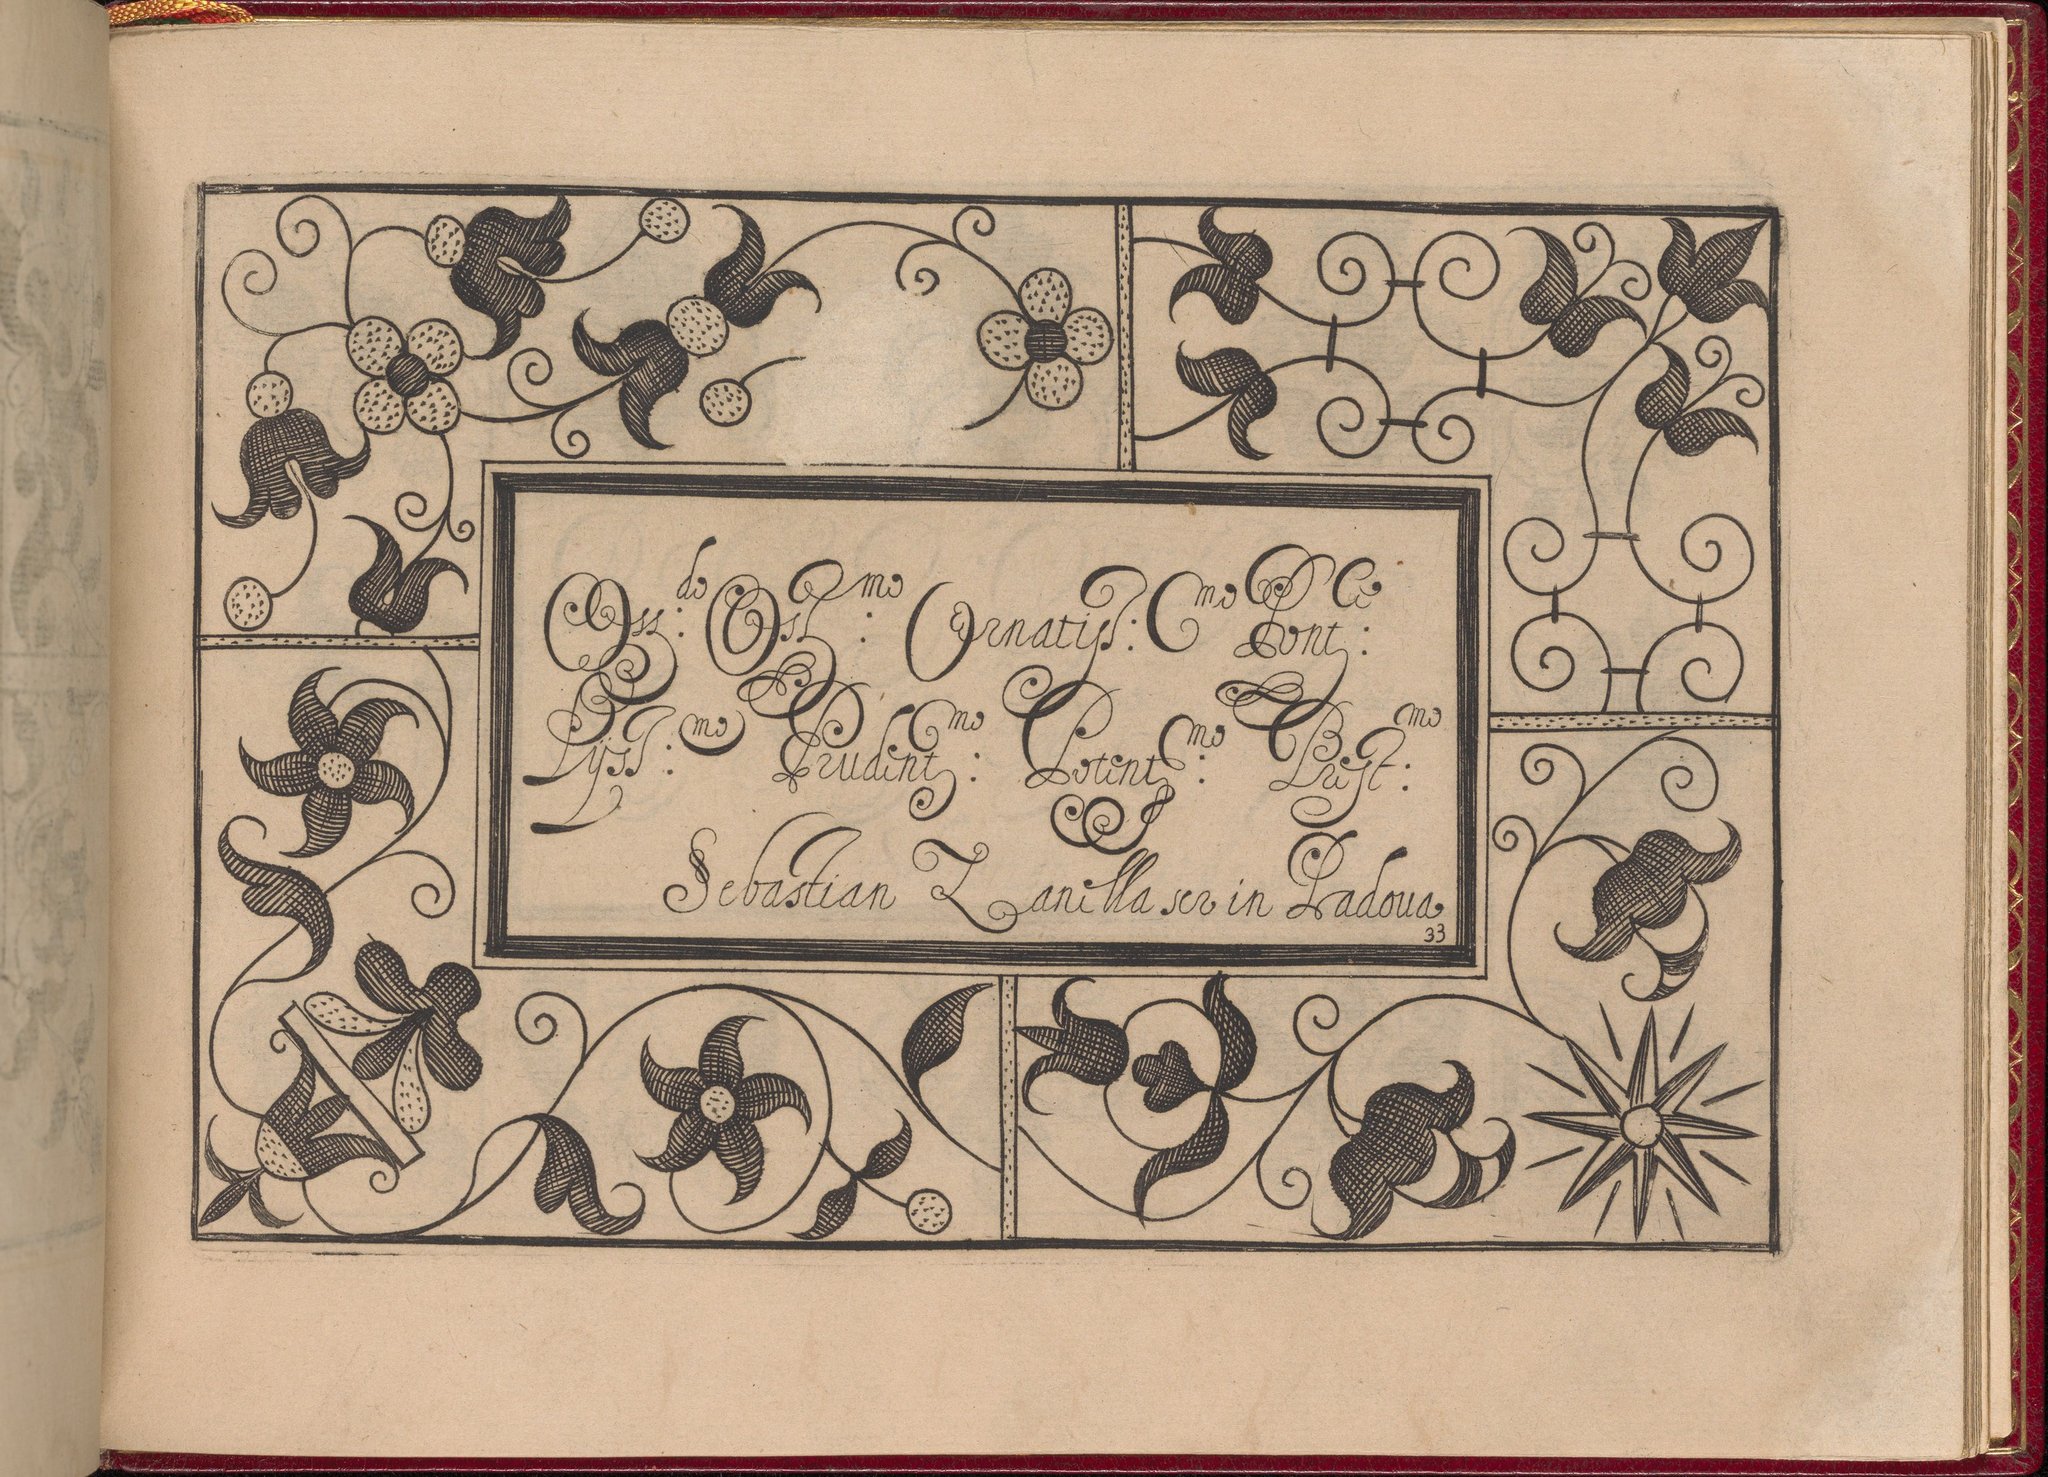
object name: book print ornament architecture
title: Ghirlanda: Di sei vaghi fiori scielti da piu famosi Giardini d'Italia, page 41 (recto)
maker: pietro paulo tozzi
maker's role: designer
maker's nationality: italian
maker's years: 1593-1628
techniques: drawing, etching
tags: flowers